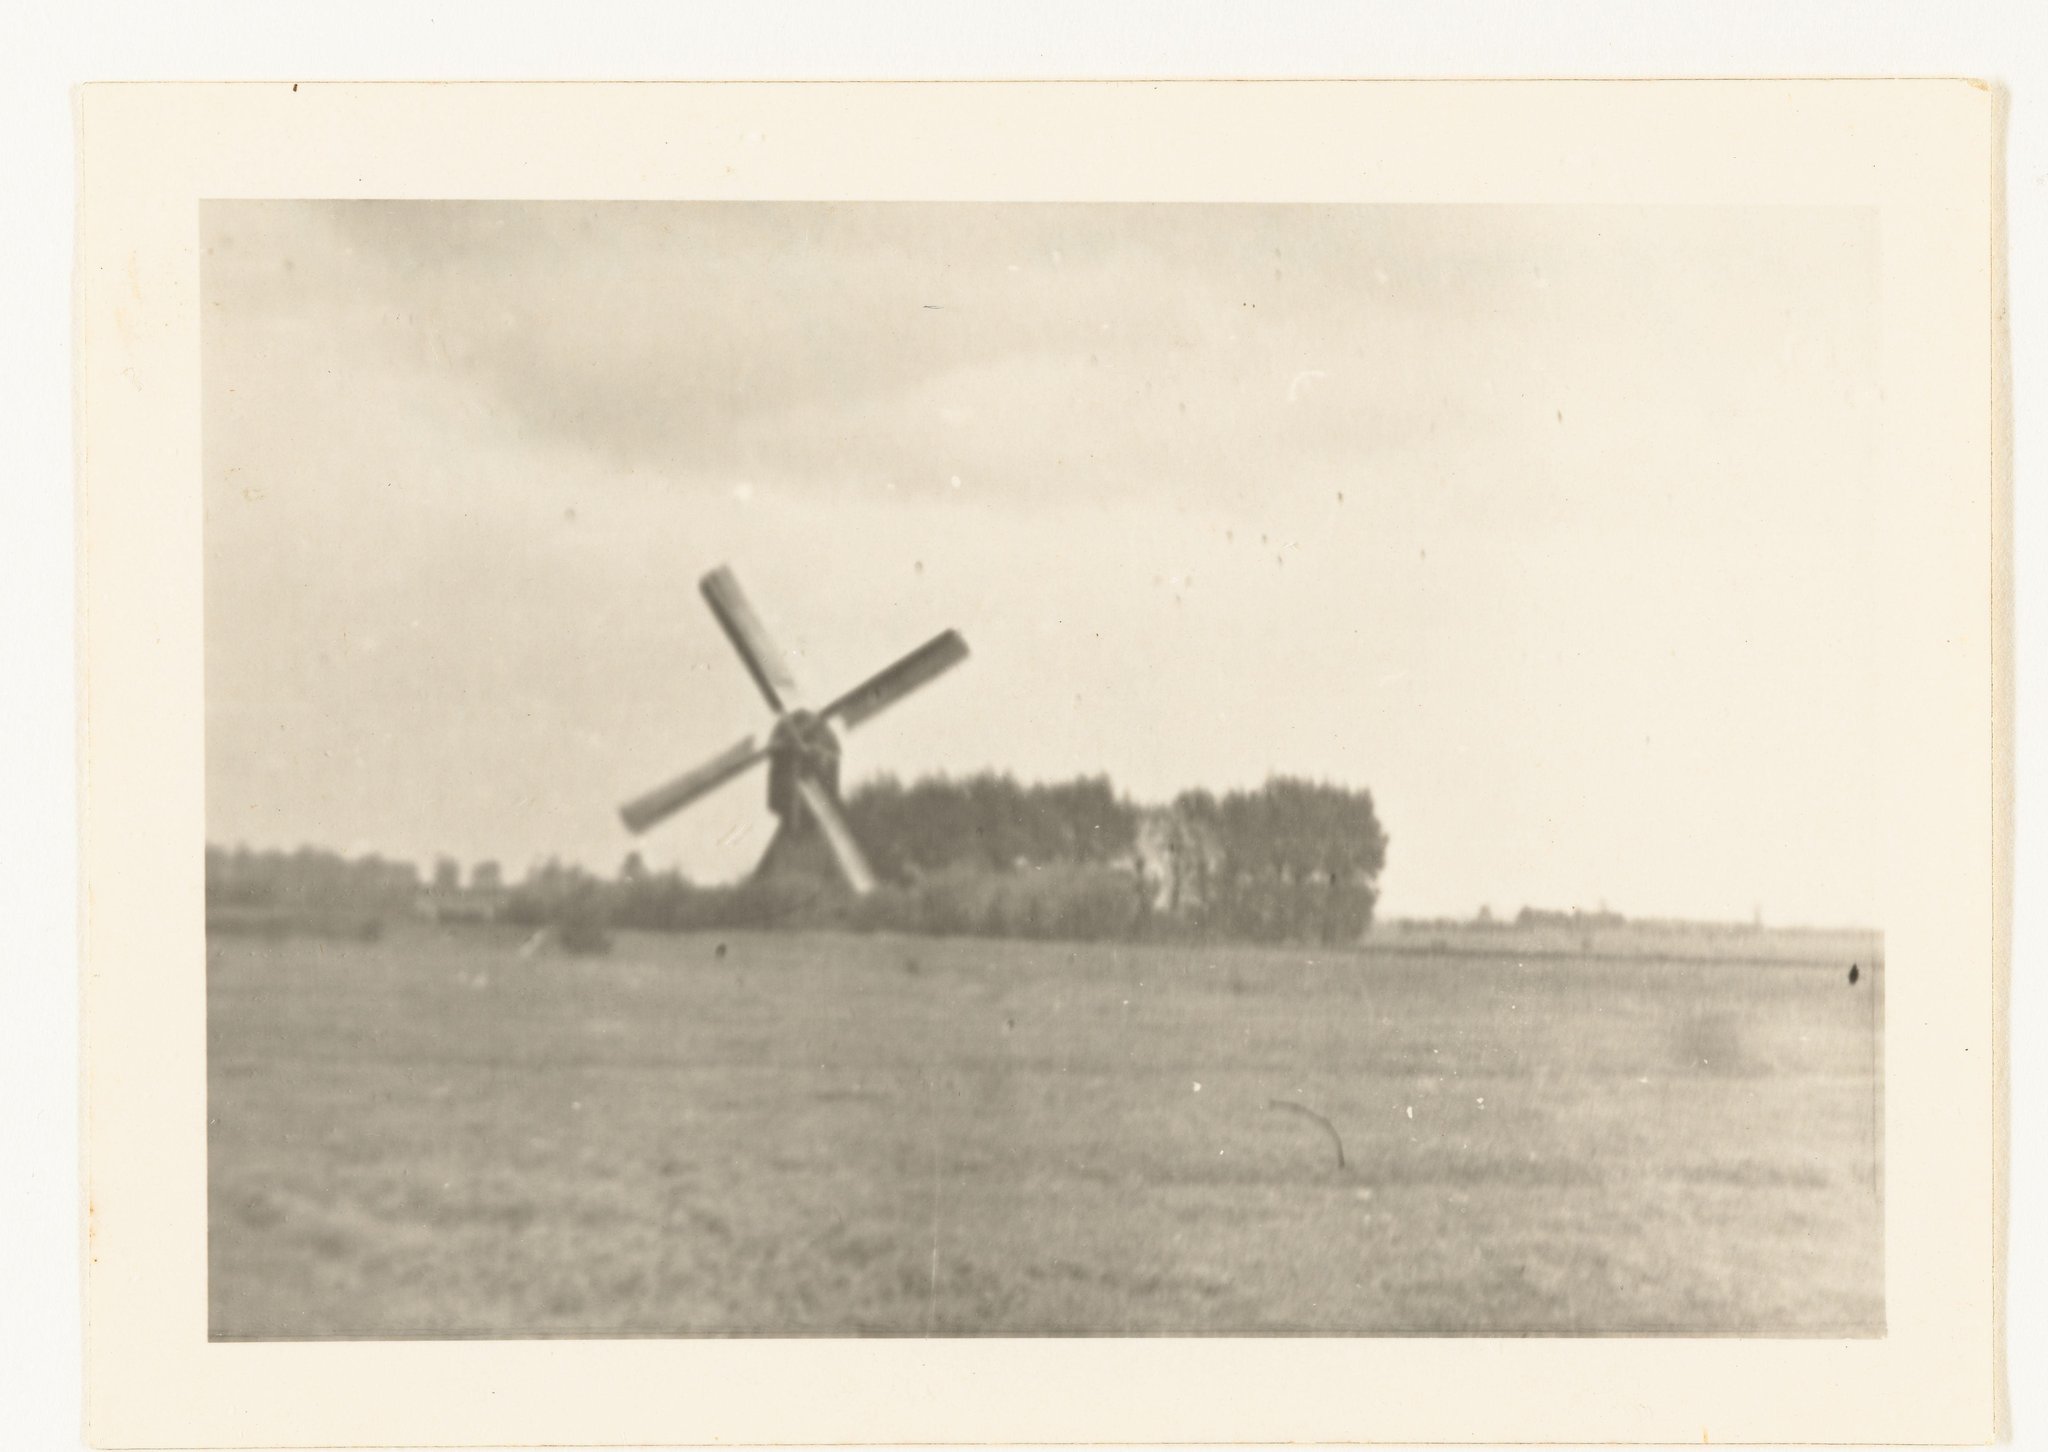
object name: photograph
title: Molen in weiland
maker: Anonymous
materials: photographic support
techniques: gelatin silver print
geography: netherlands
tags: windmill, occupation ~ war, netherlands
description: Molen in een weiland. Rechts van de molen staan bomen. Tekst achterop deels onleesbaar.